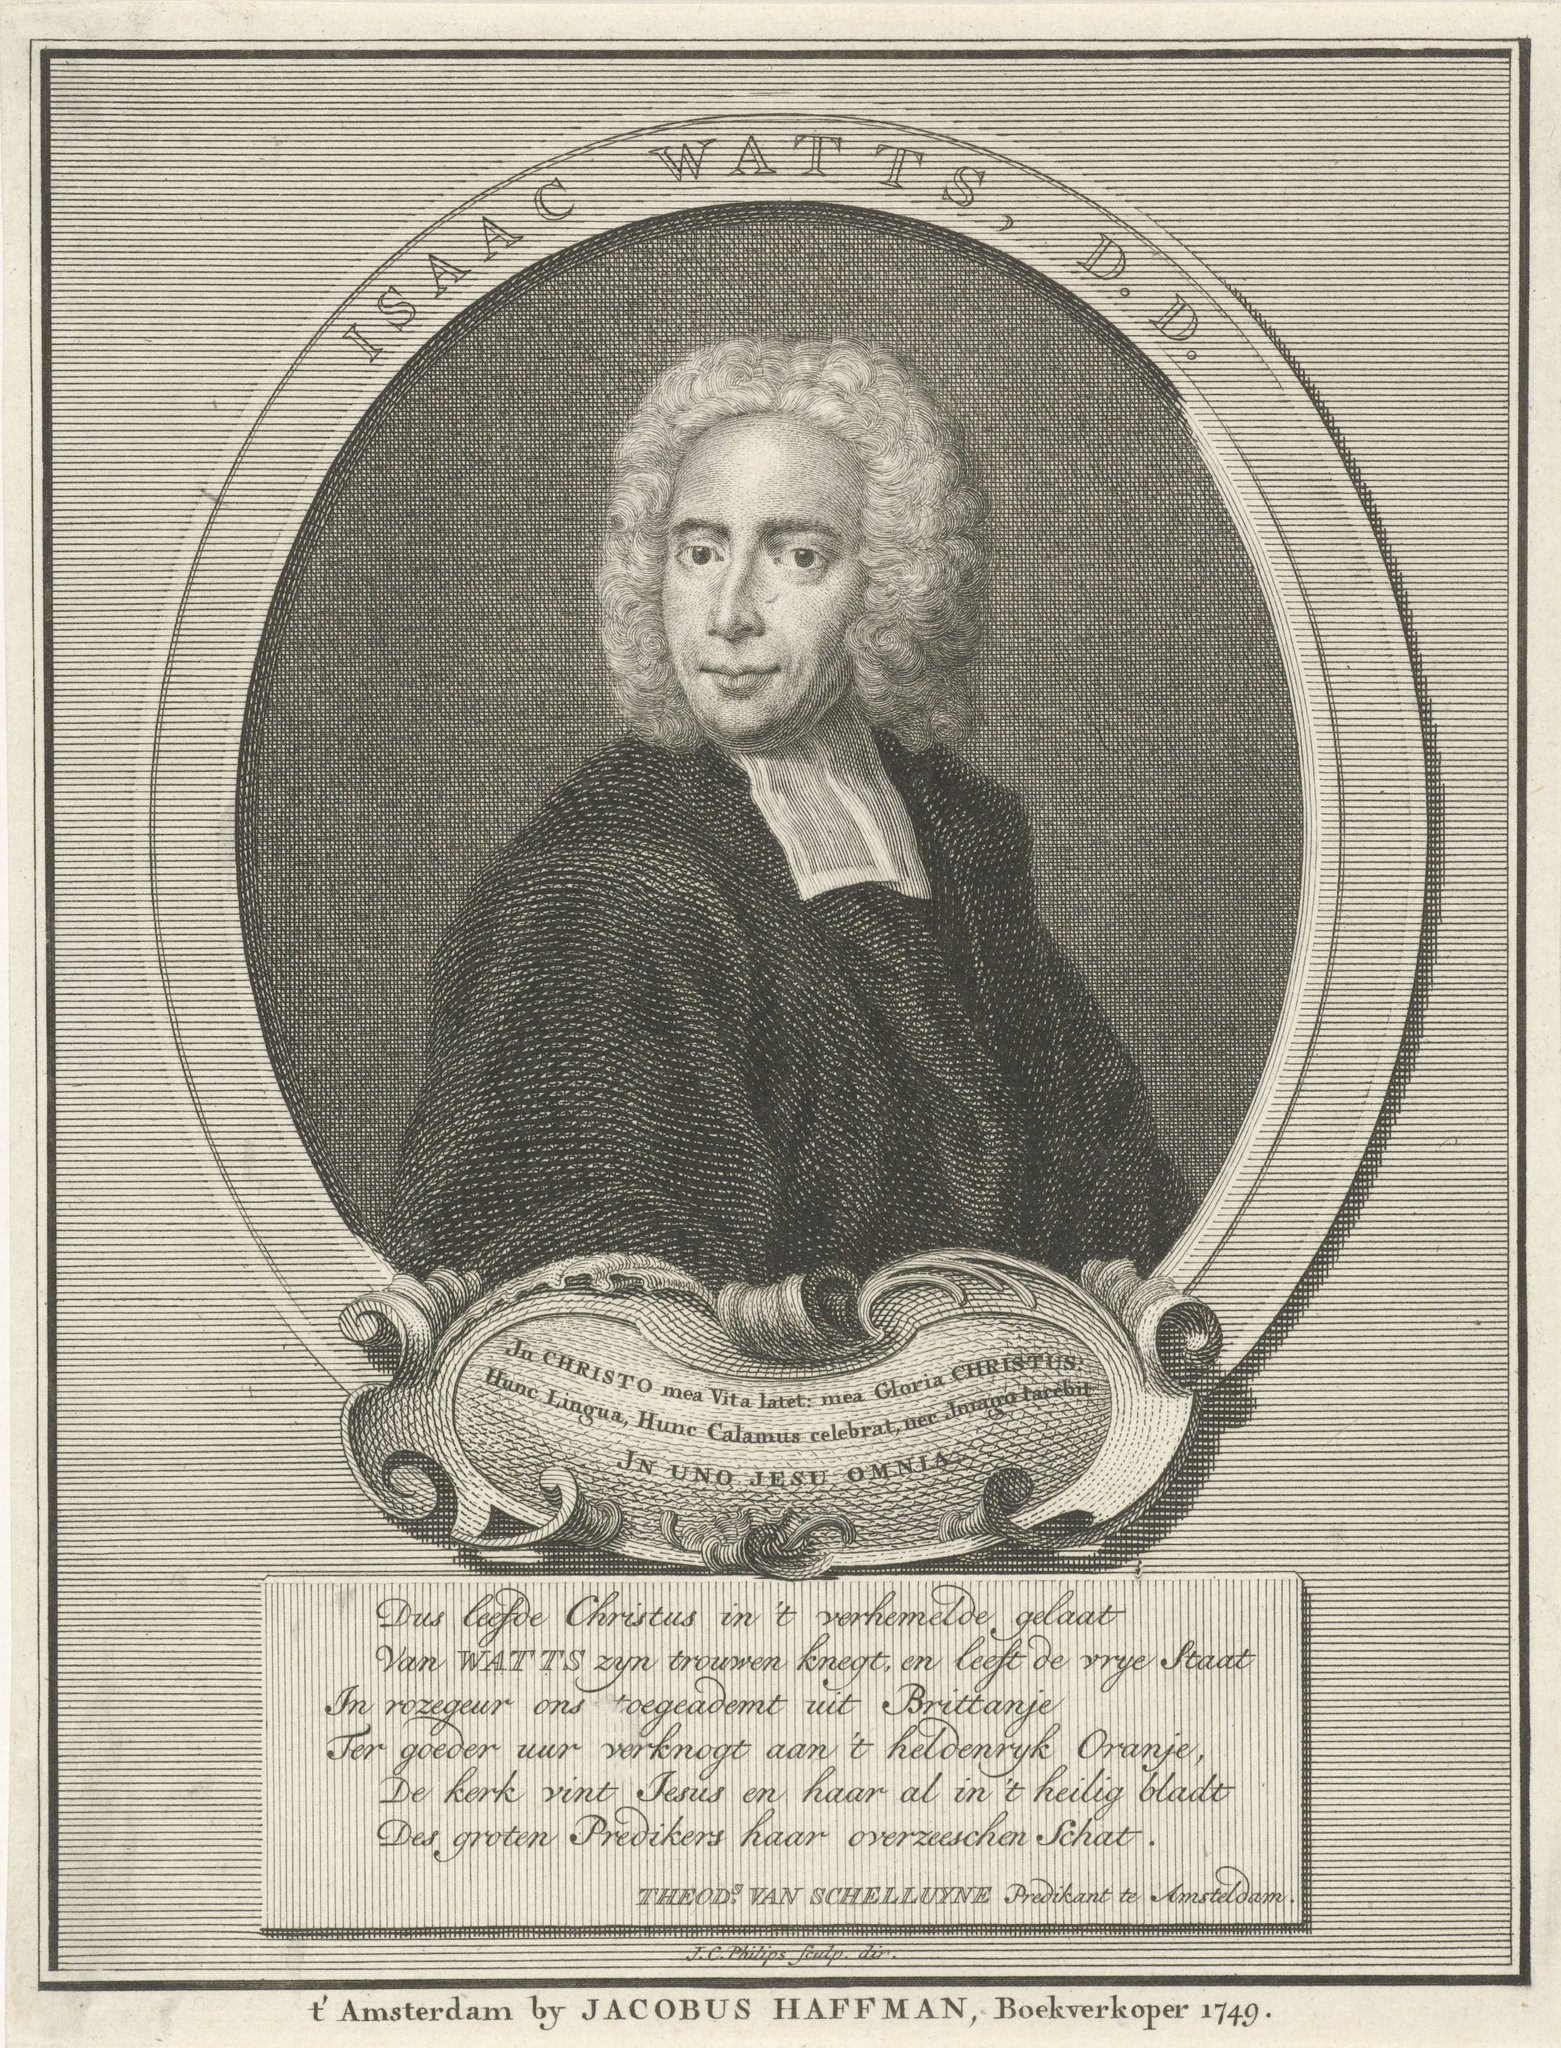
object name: print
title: Portret van Isaac Watts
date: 1749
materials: paper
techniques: engraving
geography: amsterdam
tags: schrijver, theoloog, isaac watts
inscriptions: collector's mark: Lugt 2228